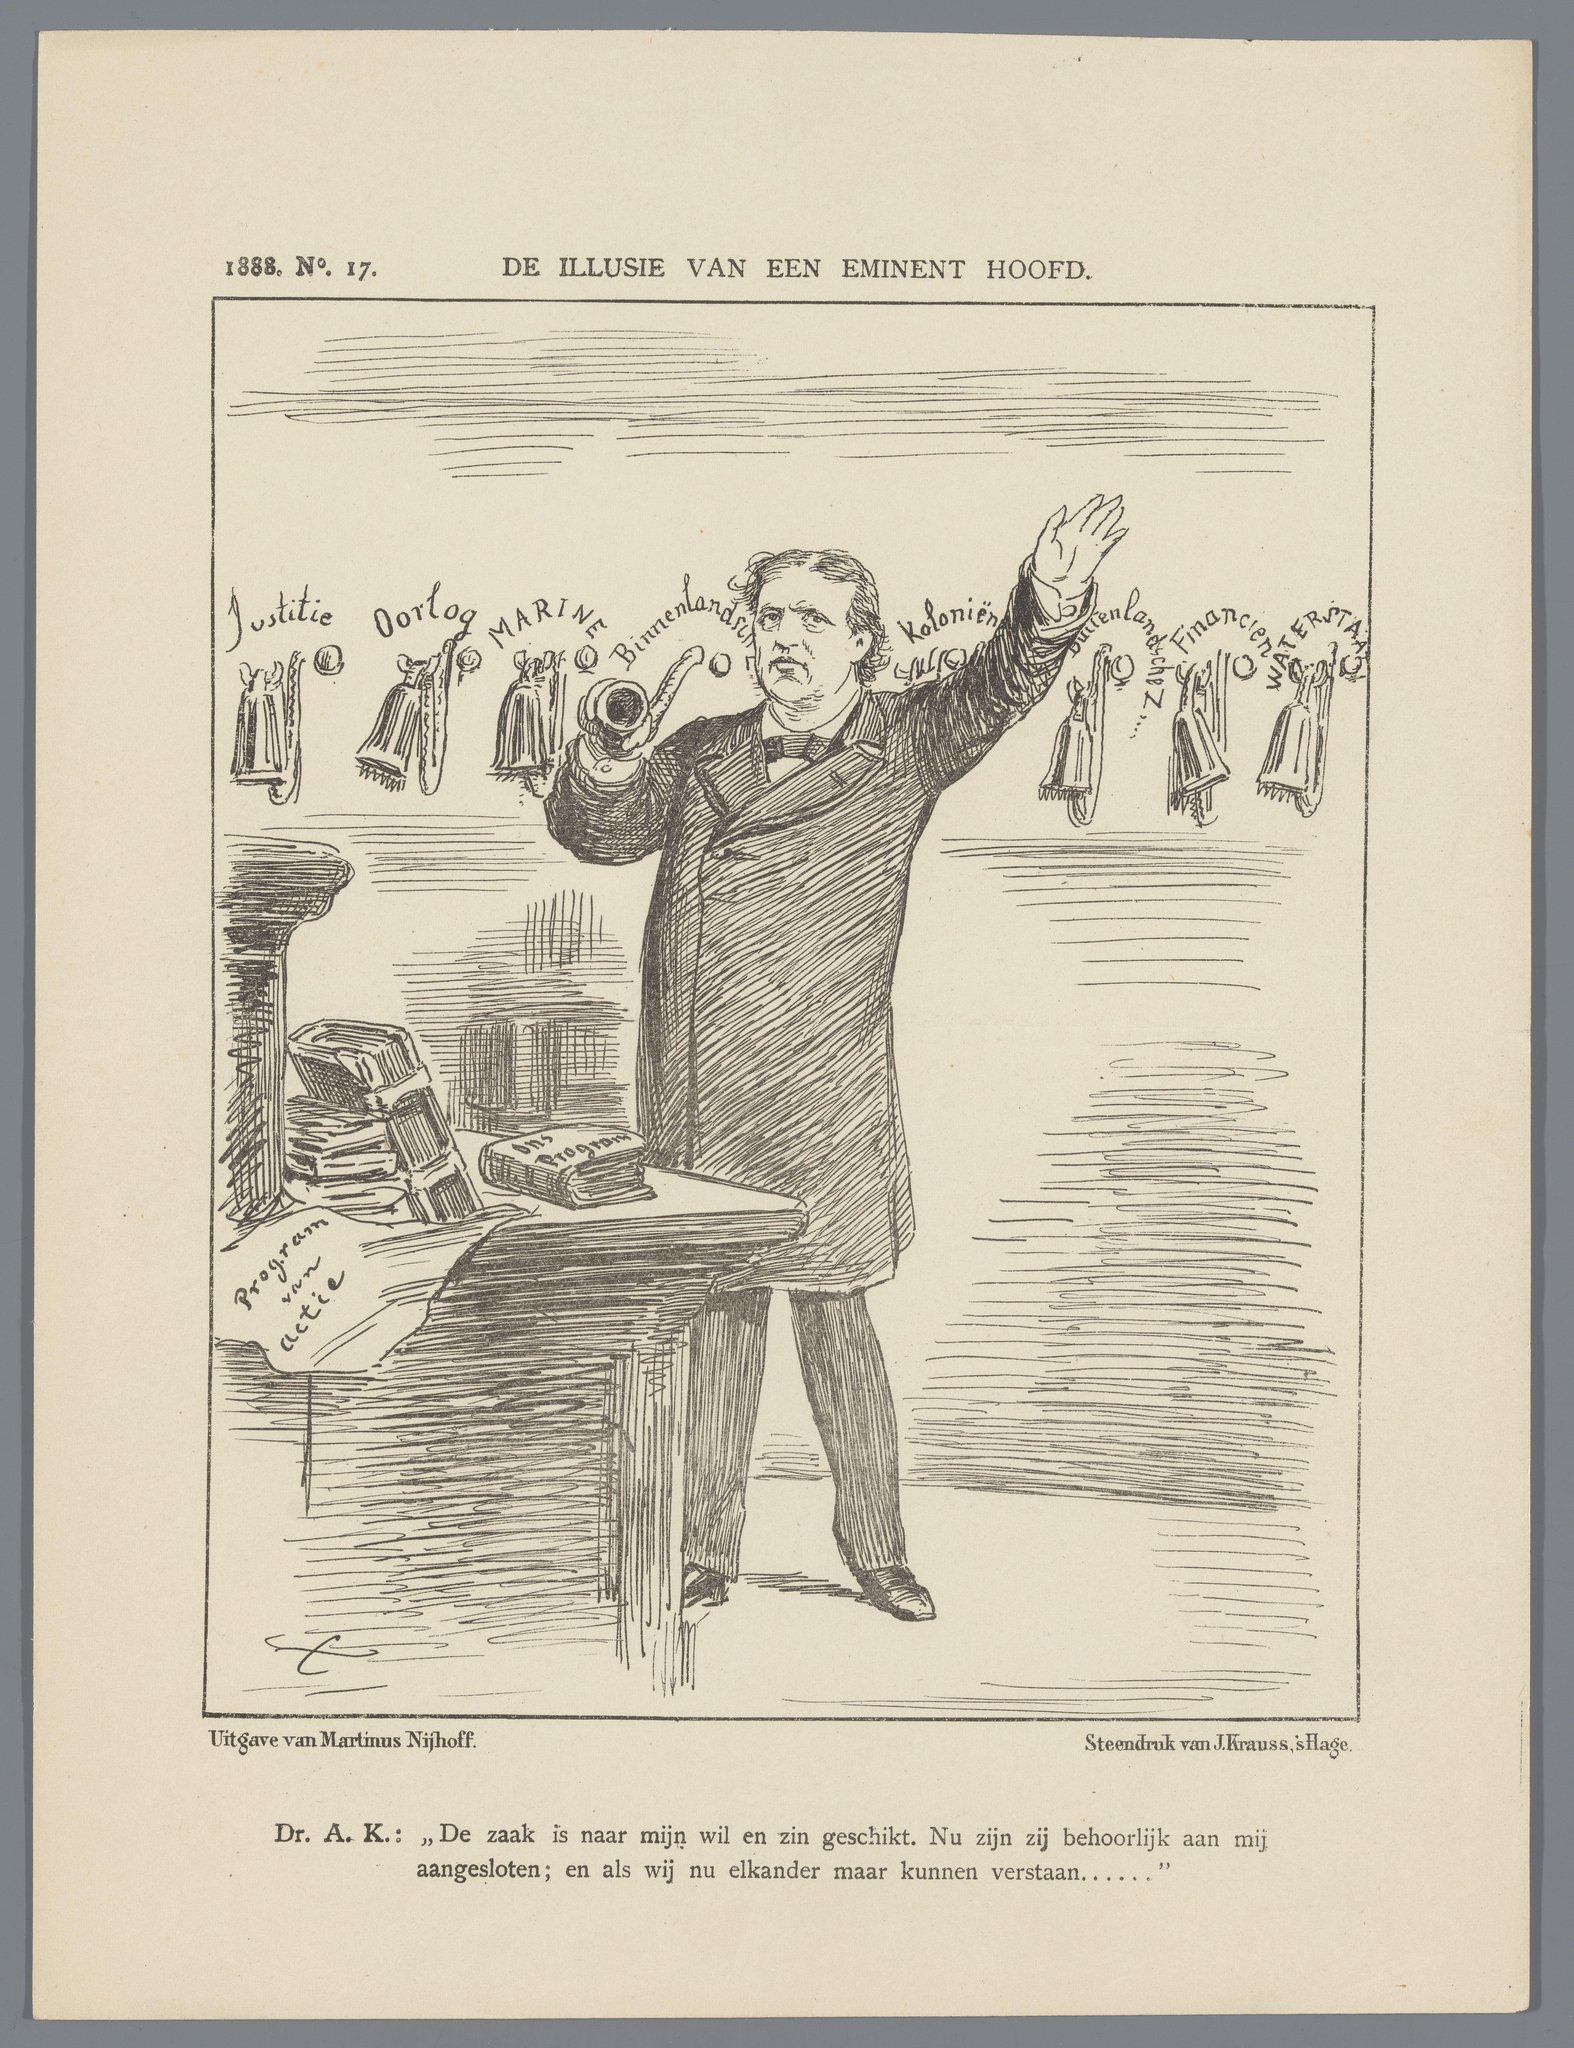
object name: print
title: De illusie van een eminent hoofd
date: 1888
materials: paper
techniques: lithograph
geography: netherlands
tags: abraham kuyper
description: Spotprent met Abraham Kuyper. Plaat verschenen bij het weekblad De Nederlandsche Spectator, nr. 17, 1888.